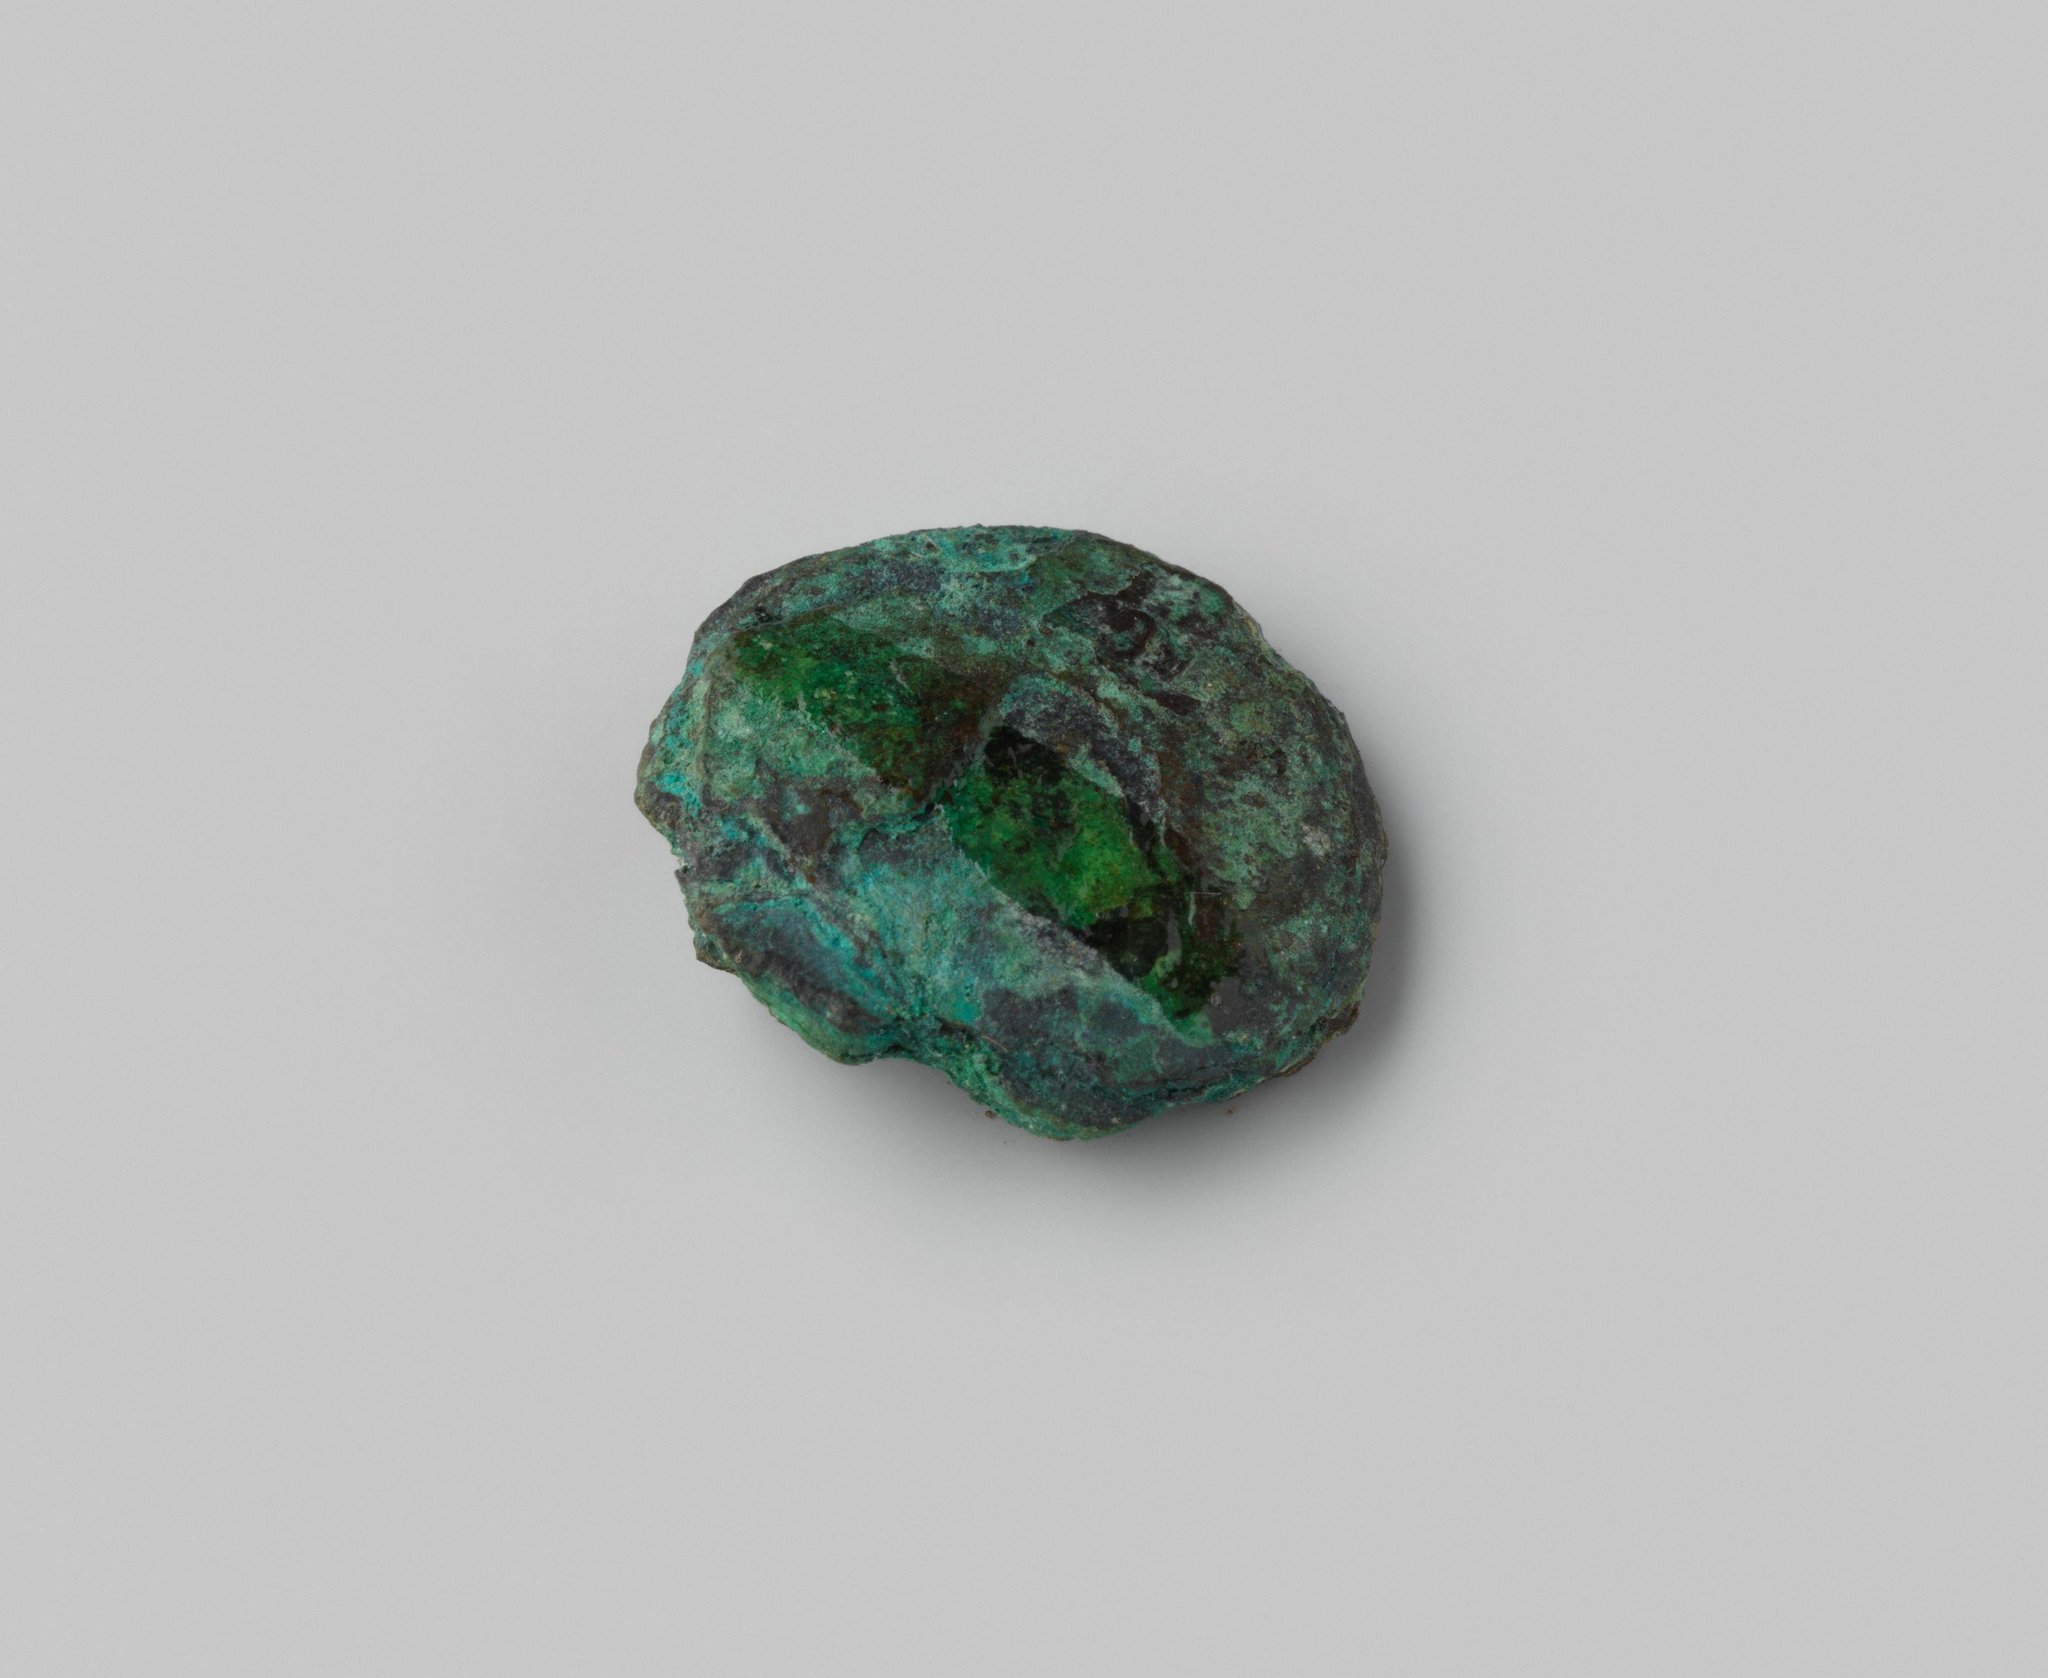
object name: rivet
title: Fragment klinknagel afkomstig uit het wrak van de Oost-Indiëvaarder Hollandia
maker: Anonymous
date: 1700-1743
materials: copper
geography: netherlands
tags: verenigde oostindische compagnie, hollandia (schip)